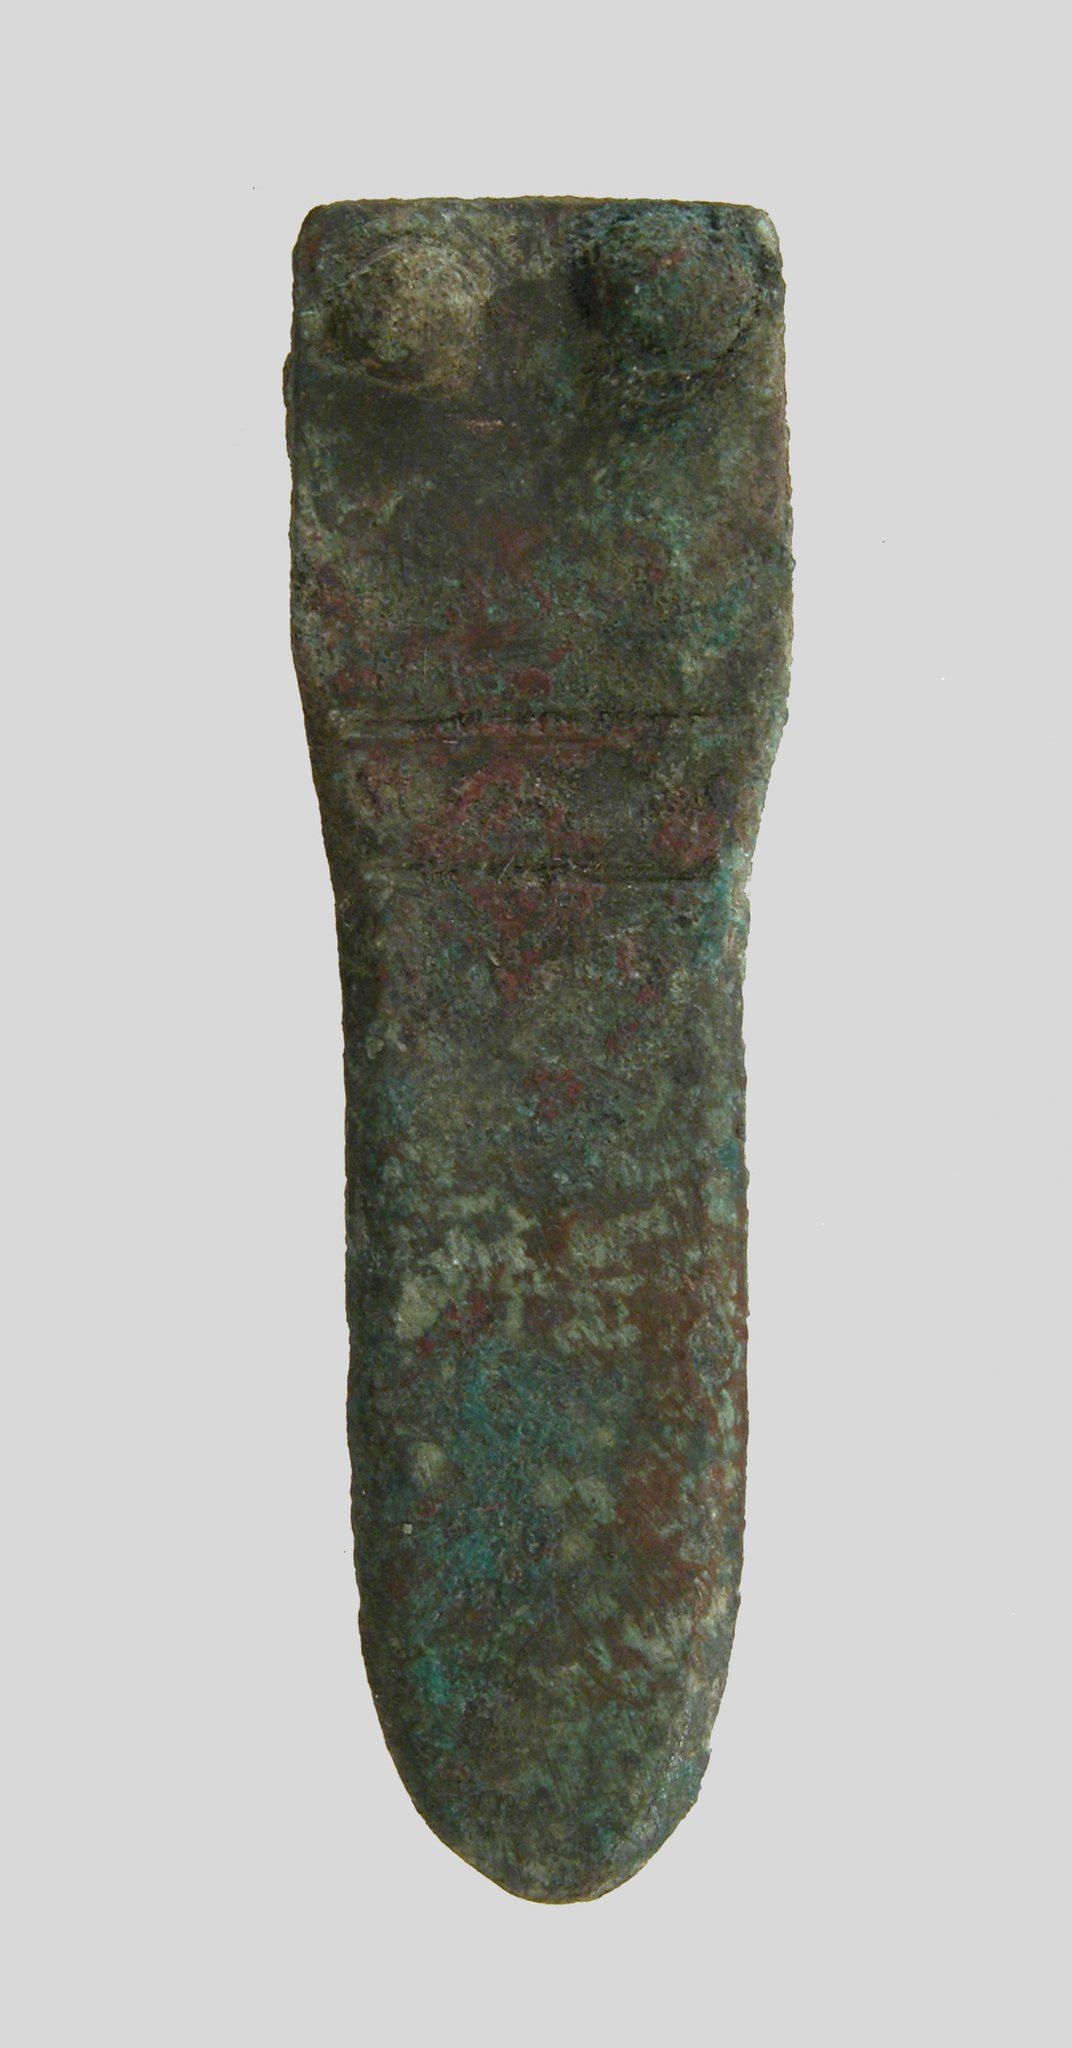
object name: ferret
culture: frankish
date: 501-700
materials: copper alloy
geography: germany